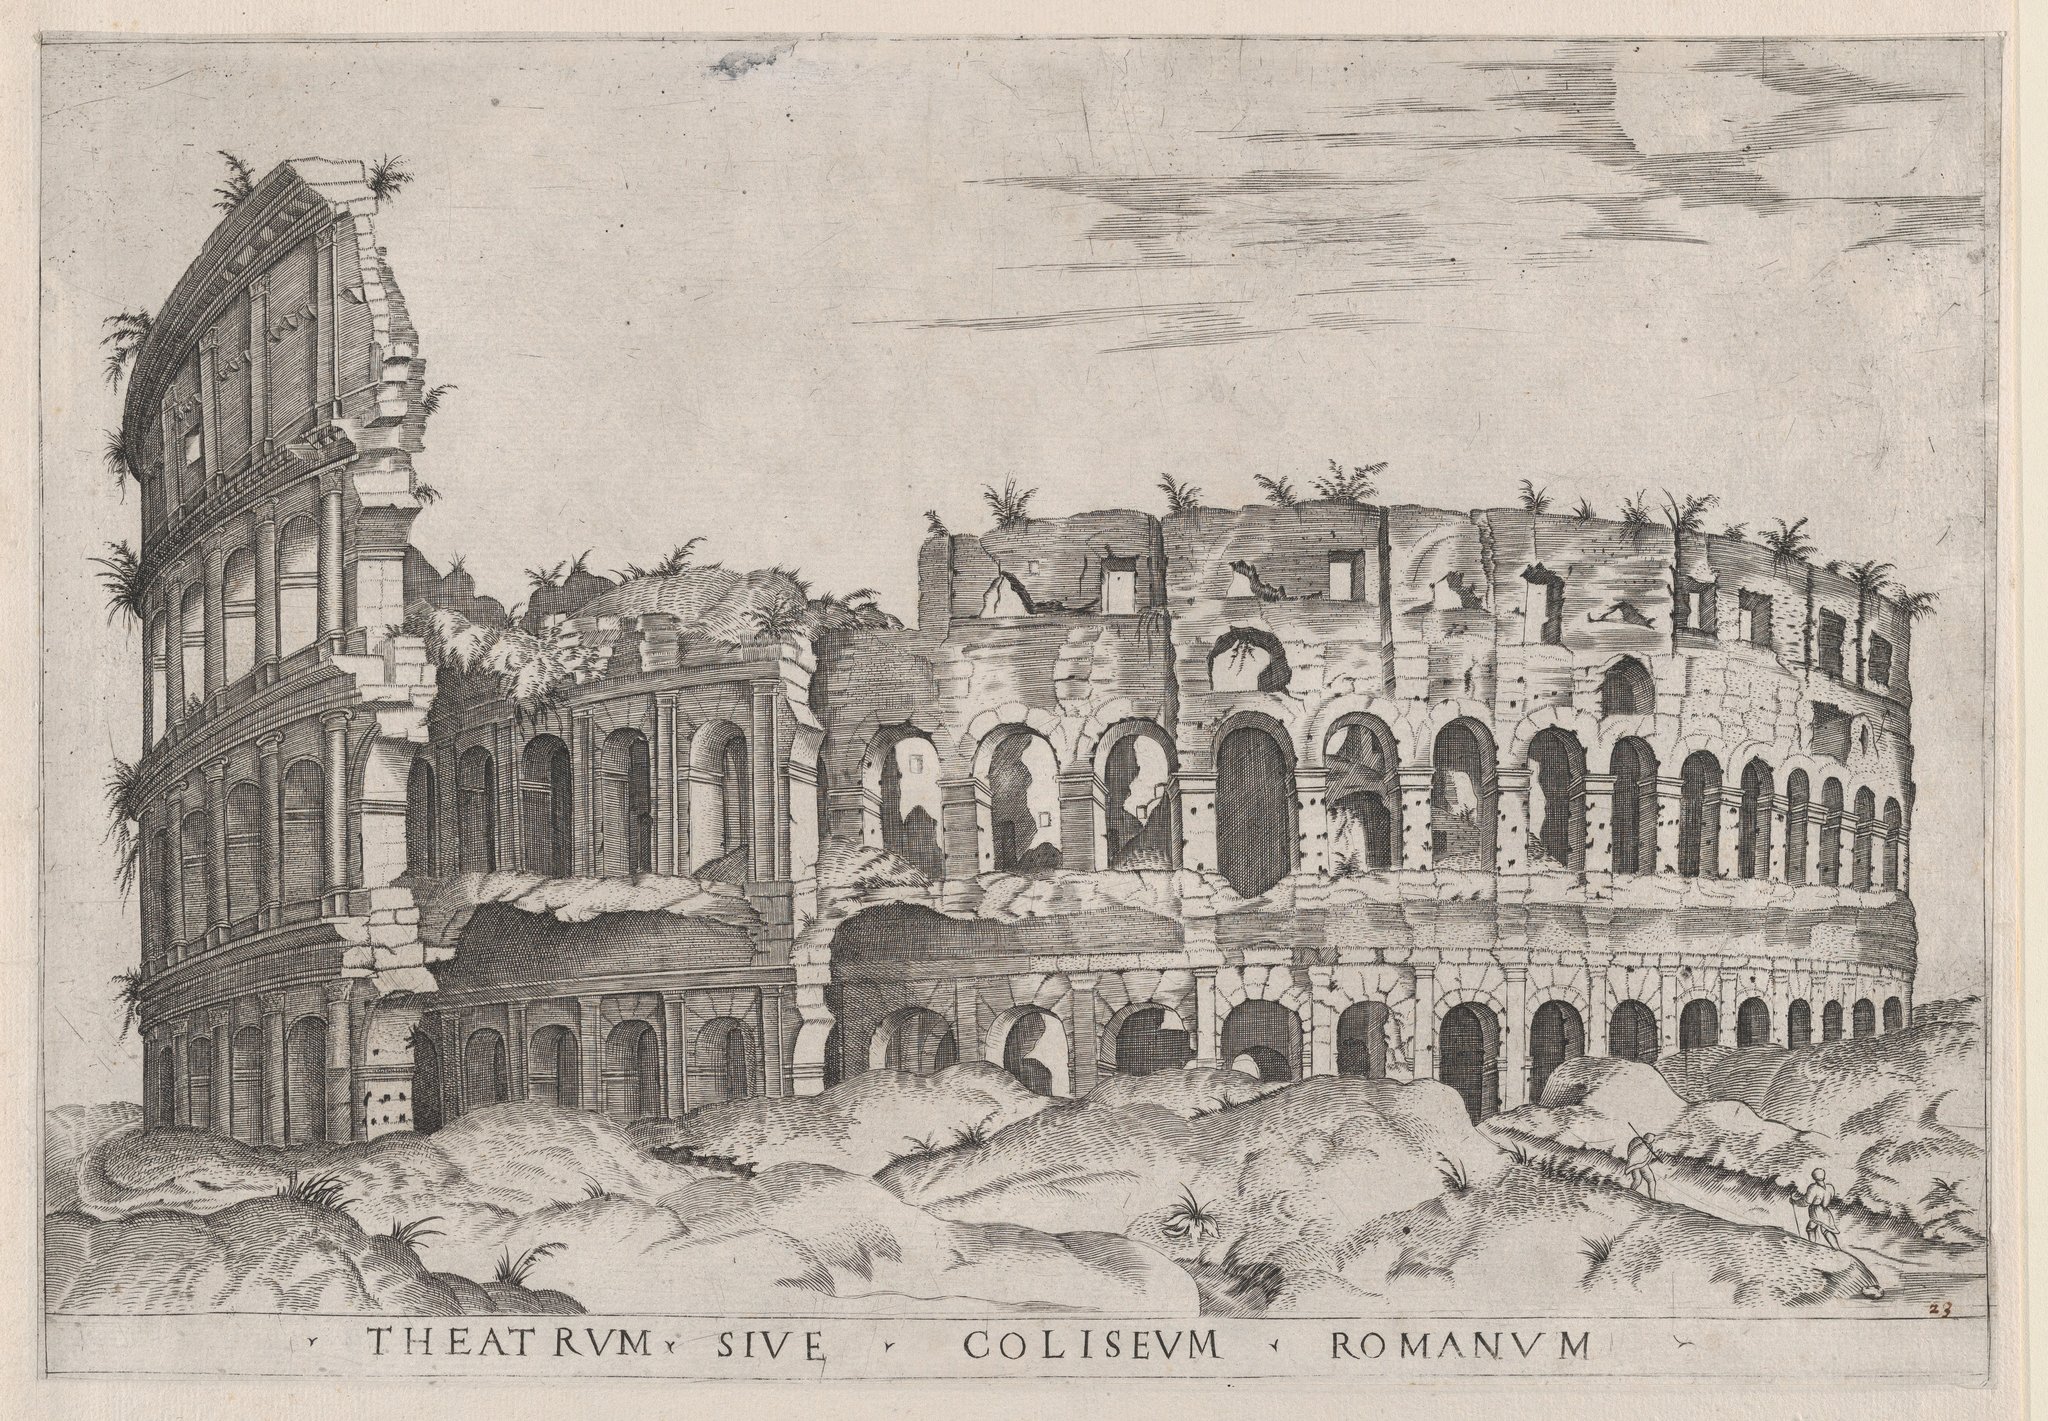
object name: print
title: The Colosseum, from "Speculum Romanae Magnificentiae"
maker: Anonymous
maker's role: artist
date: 1501-1600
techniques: engraving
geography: rome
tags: ruins,rome